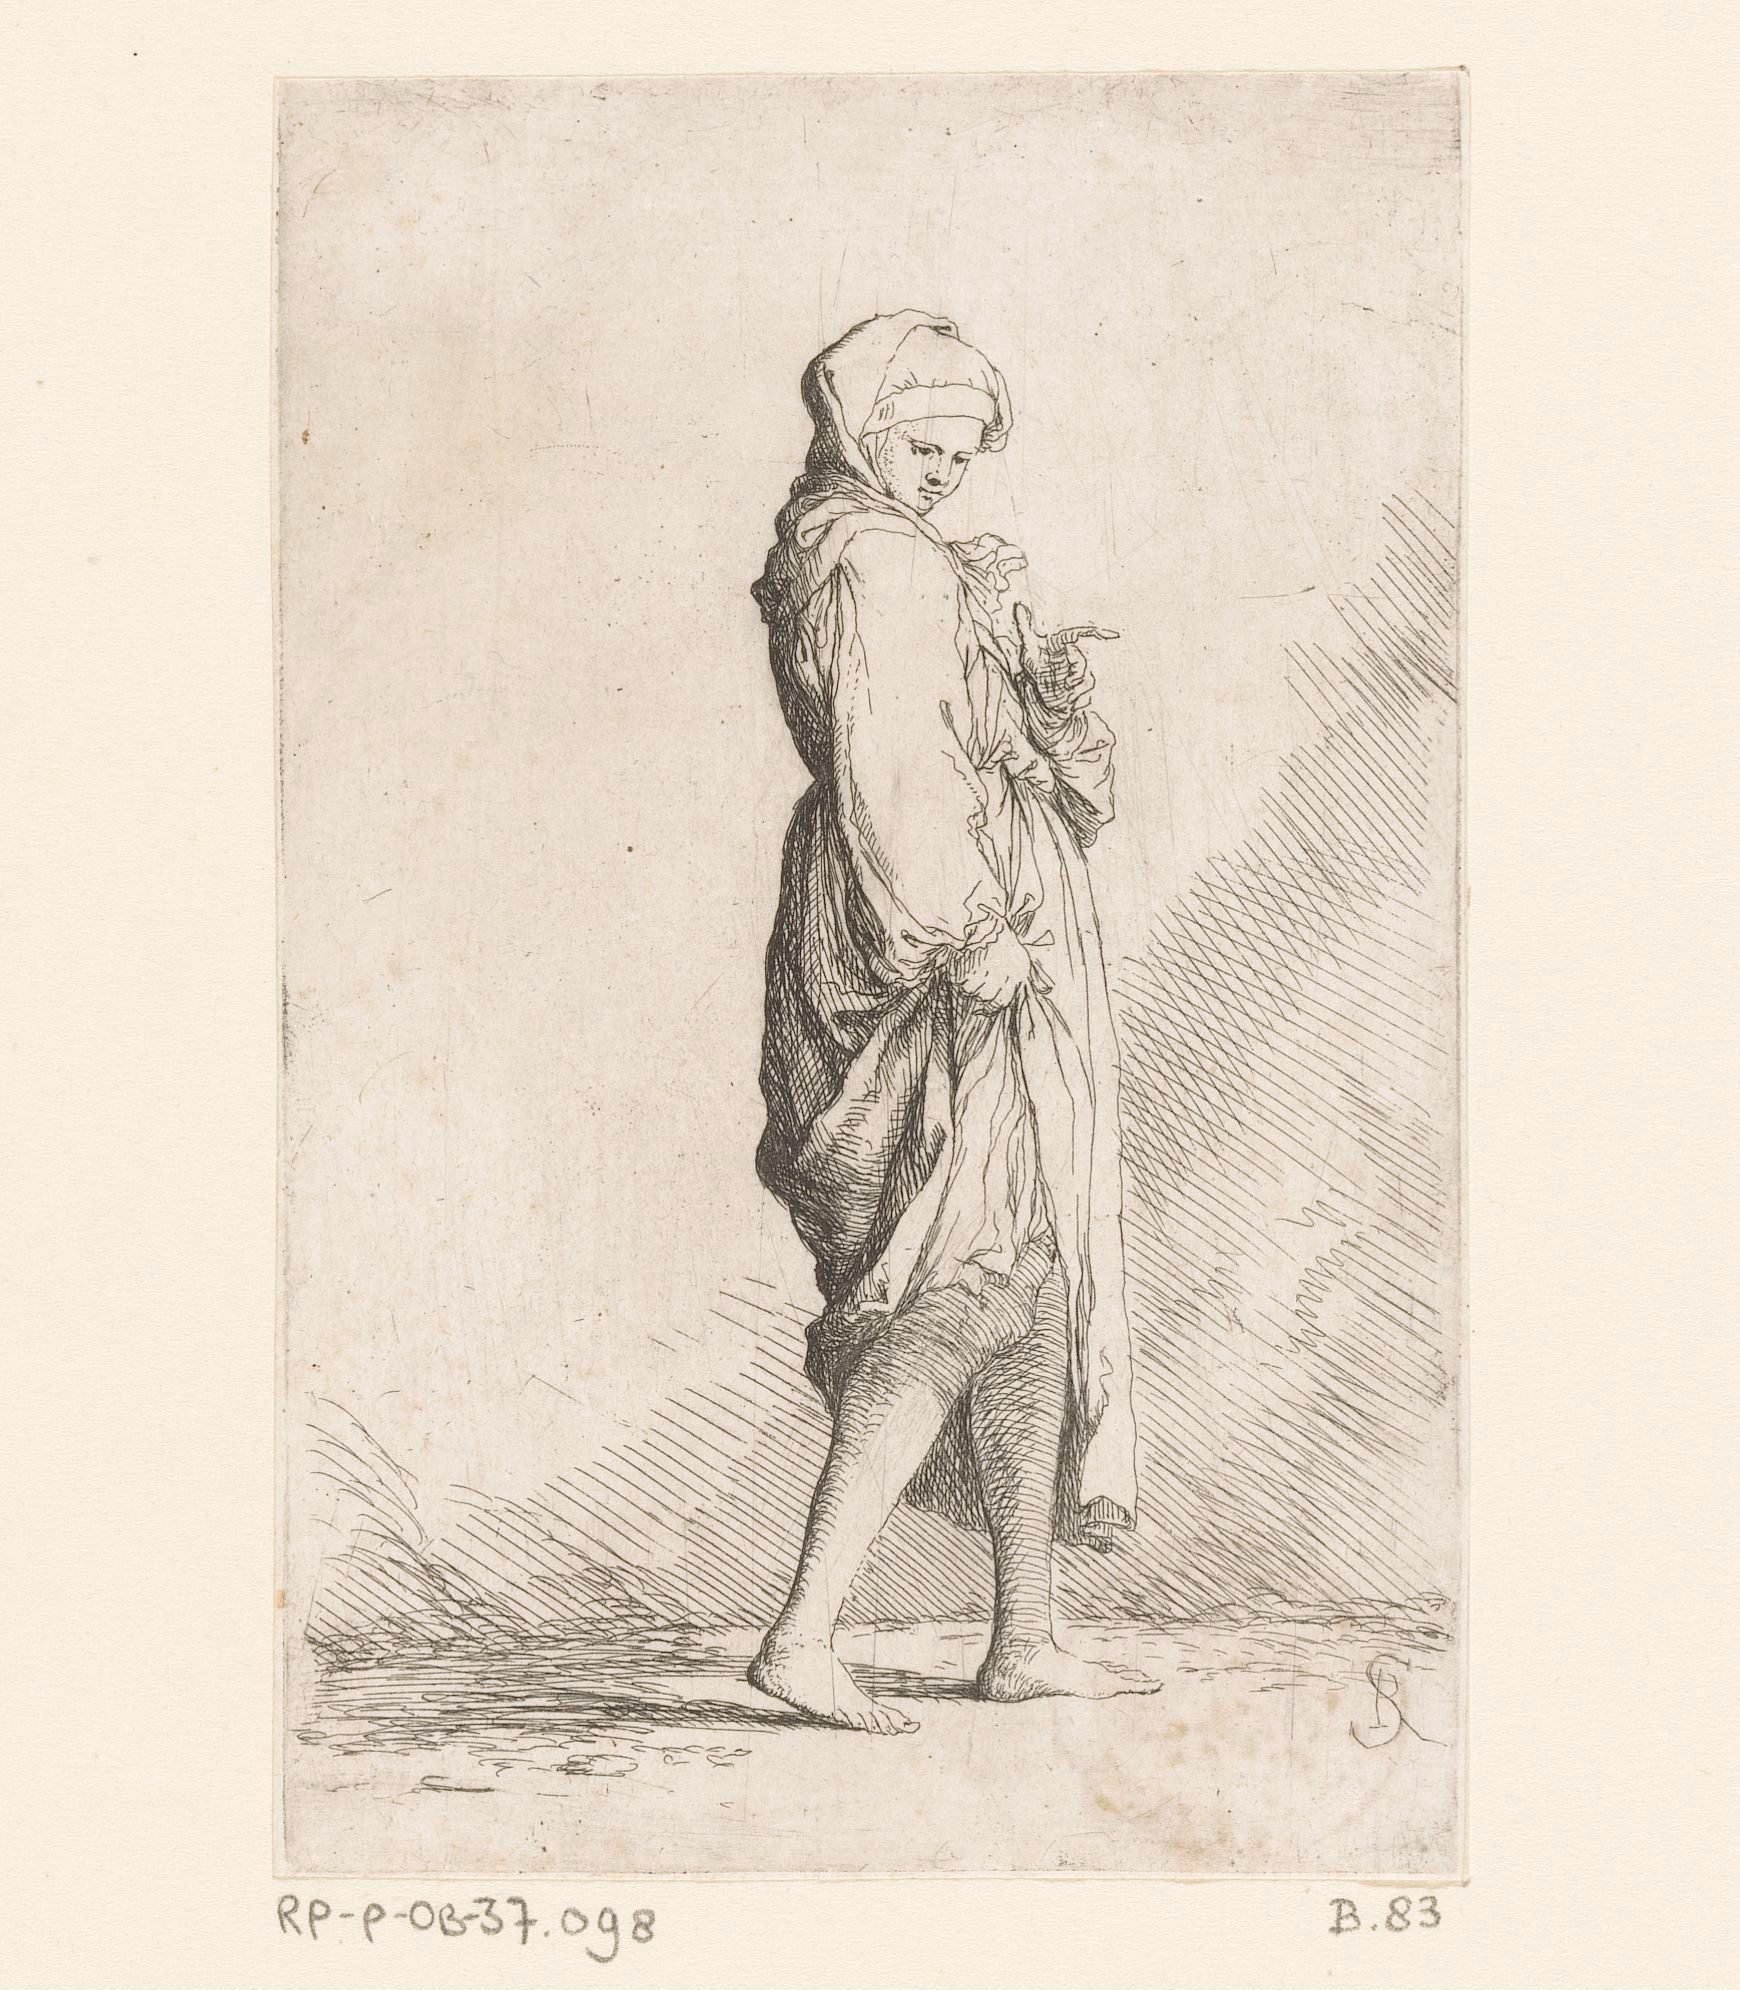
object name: print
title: Lopende vrouw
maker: salvator rosa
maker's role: draughtsman, painter, print maker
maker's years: 1615-1673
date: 1656-1657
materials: paper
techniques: drypoint, etching, intaglio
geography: italy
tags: walking - aa - female human figure, index finger forwards, pointing, indicating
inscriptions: collector's mark: Lugt 240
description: Deze prent maakt deel uit van de serie 'Figurine', bestaande uit een titelprent en 80 prenten van klein formaat met voorstellingen van mannelijke en vrouwelijke figuren. Rosa produceerde de serie waarschijnlijk gedurende de jaren 1656 en 1657.